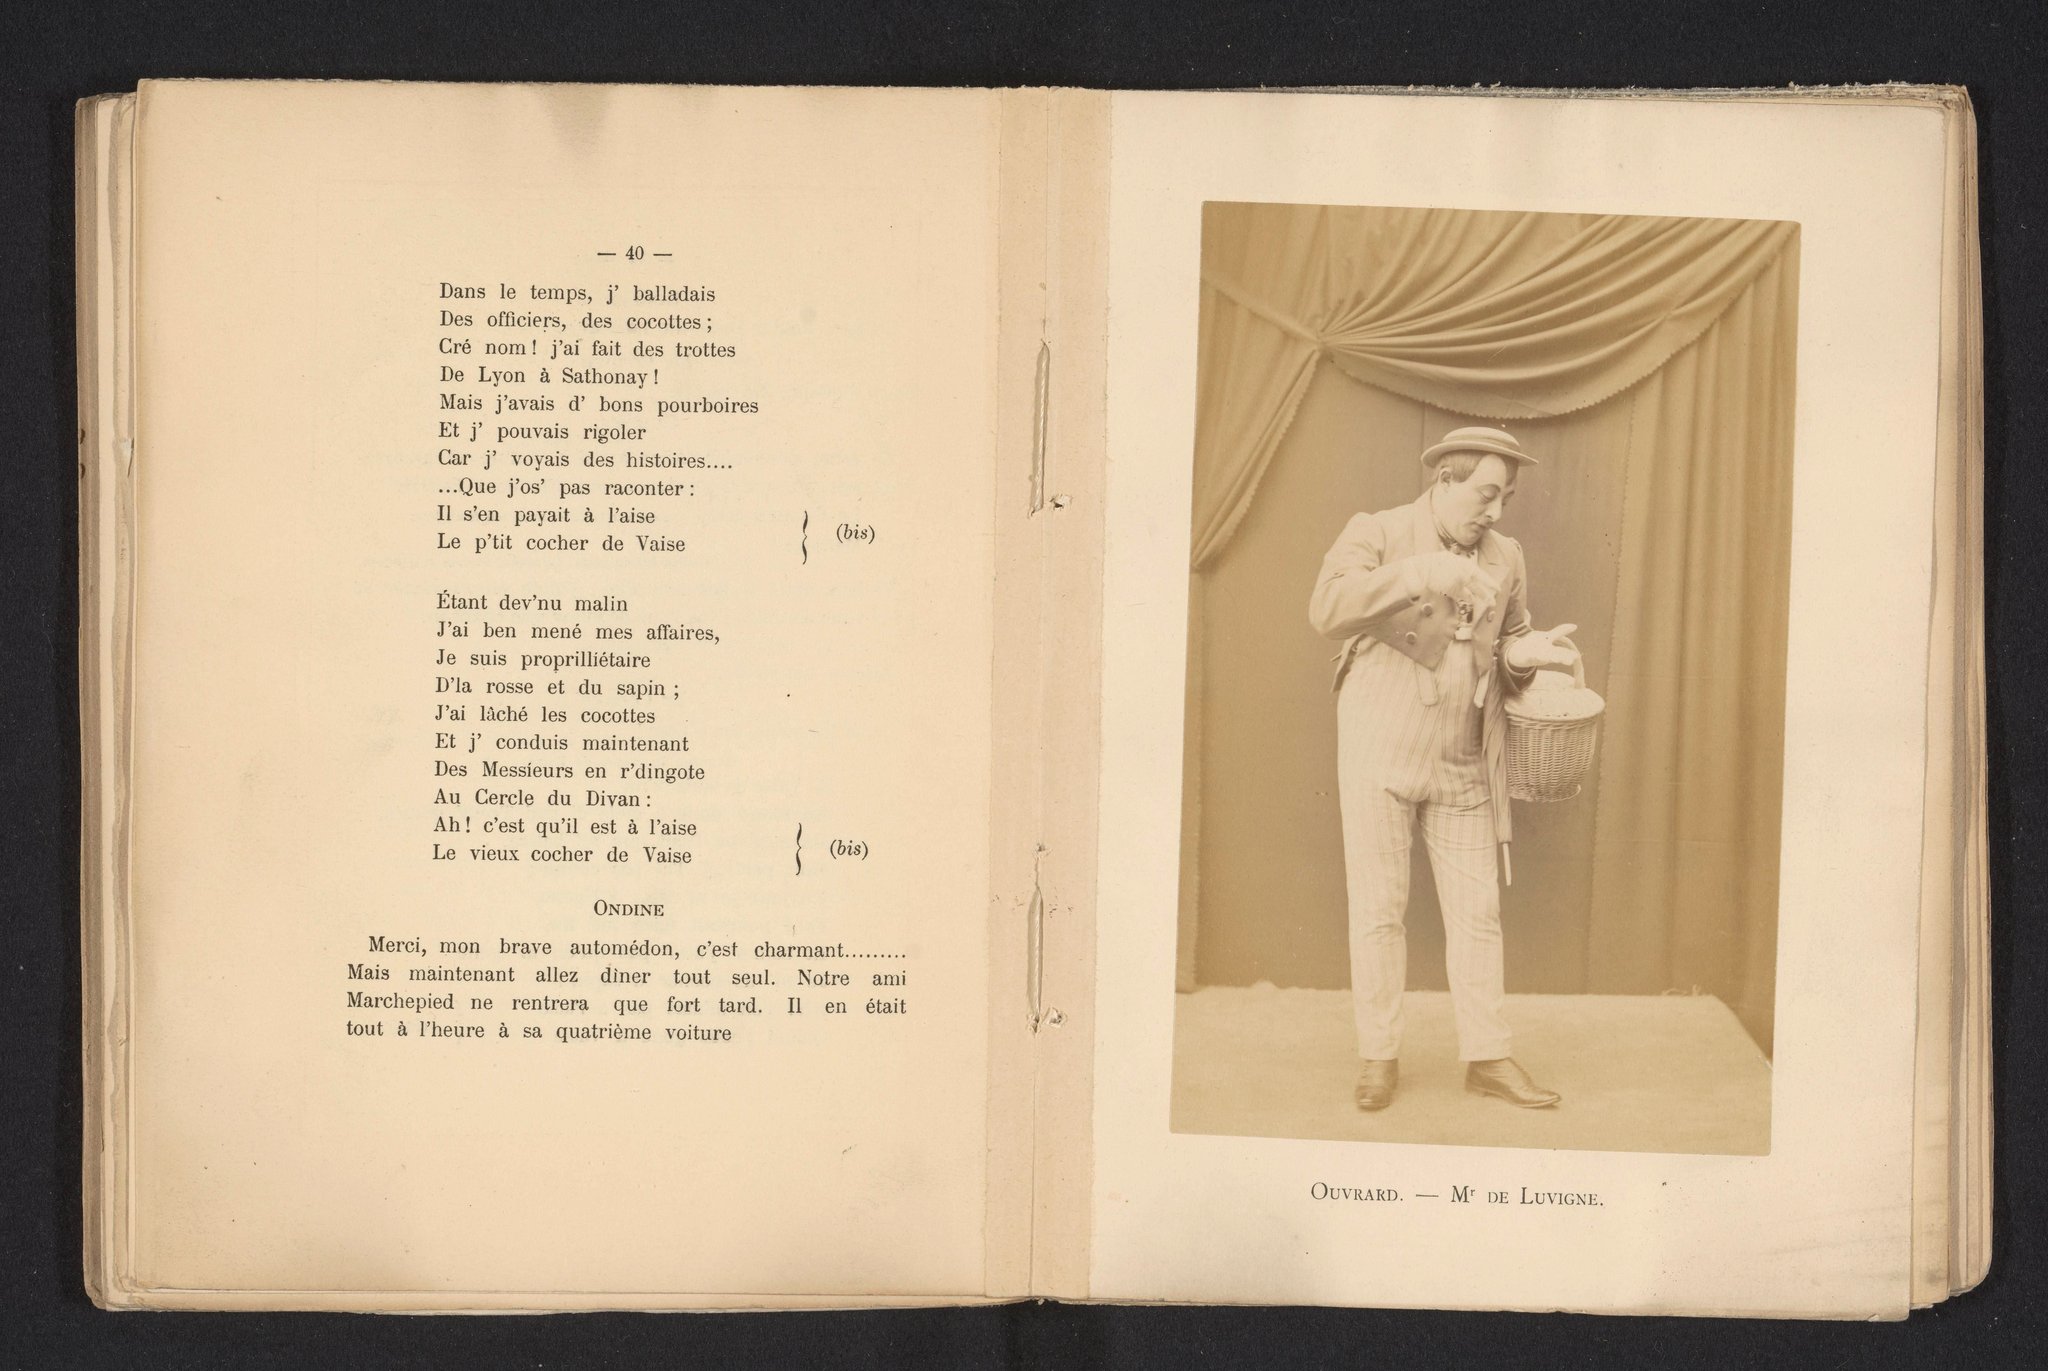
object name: photograph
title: Portret van de heer De Luvigne vermoedelijk verkleed als Gaston Ouvrard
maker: Anonymous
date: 1803-1891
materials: photographic support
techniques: albumen print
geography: lyon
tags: actor (on the stage)